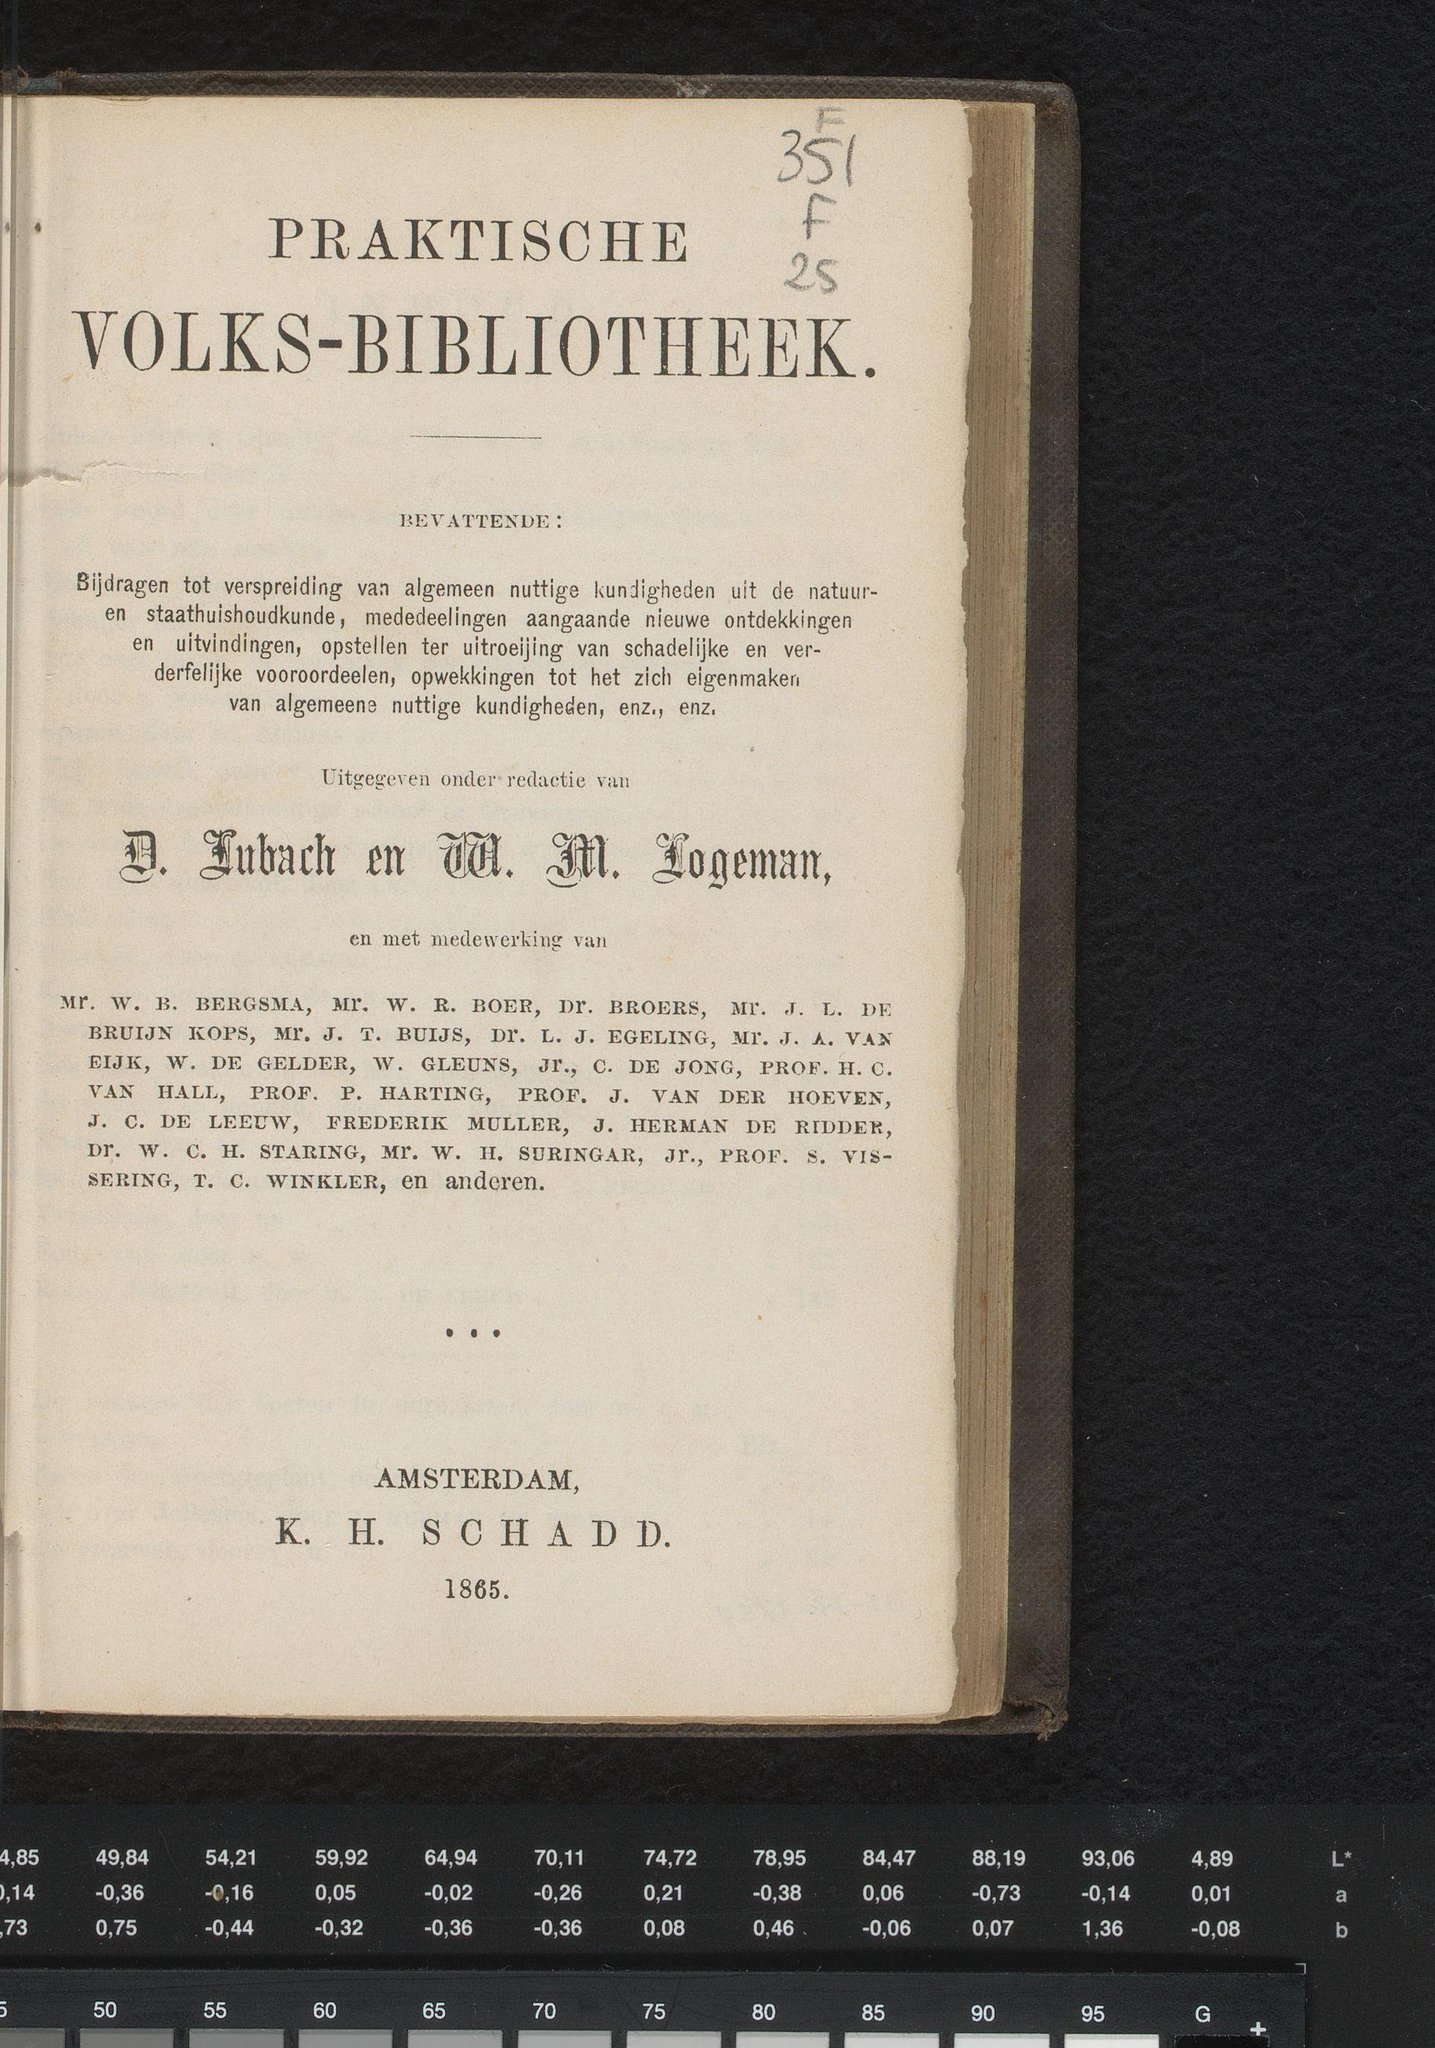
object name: book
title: Praktische volks-bibliotheek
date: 1865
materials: cardboard, paper, textile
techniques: albumen print, letterpress printing, lithograph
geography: amsterdam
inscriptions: retailer's mark: ‘A. Beukhof/ Boekbinder/ Amsterdam’, inscription: ‘Rijksdienst Beeldende Kunst’, inscription: ‘5.- 760904’, inscription: ‘Cf deel 2 titelplaat en/ p. 163 w’